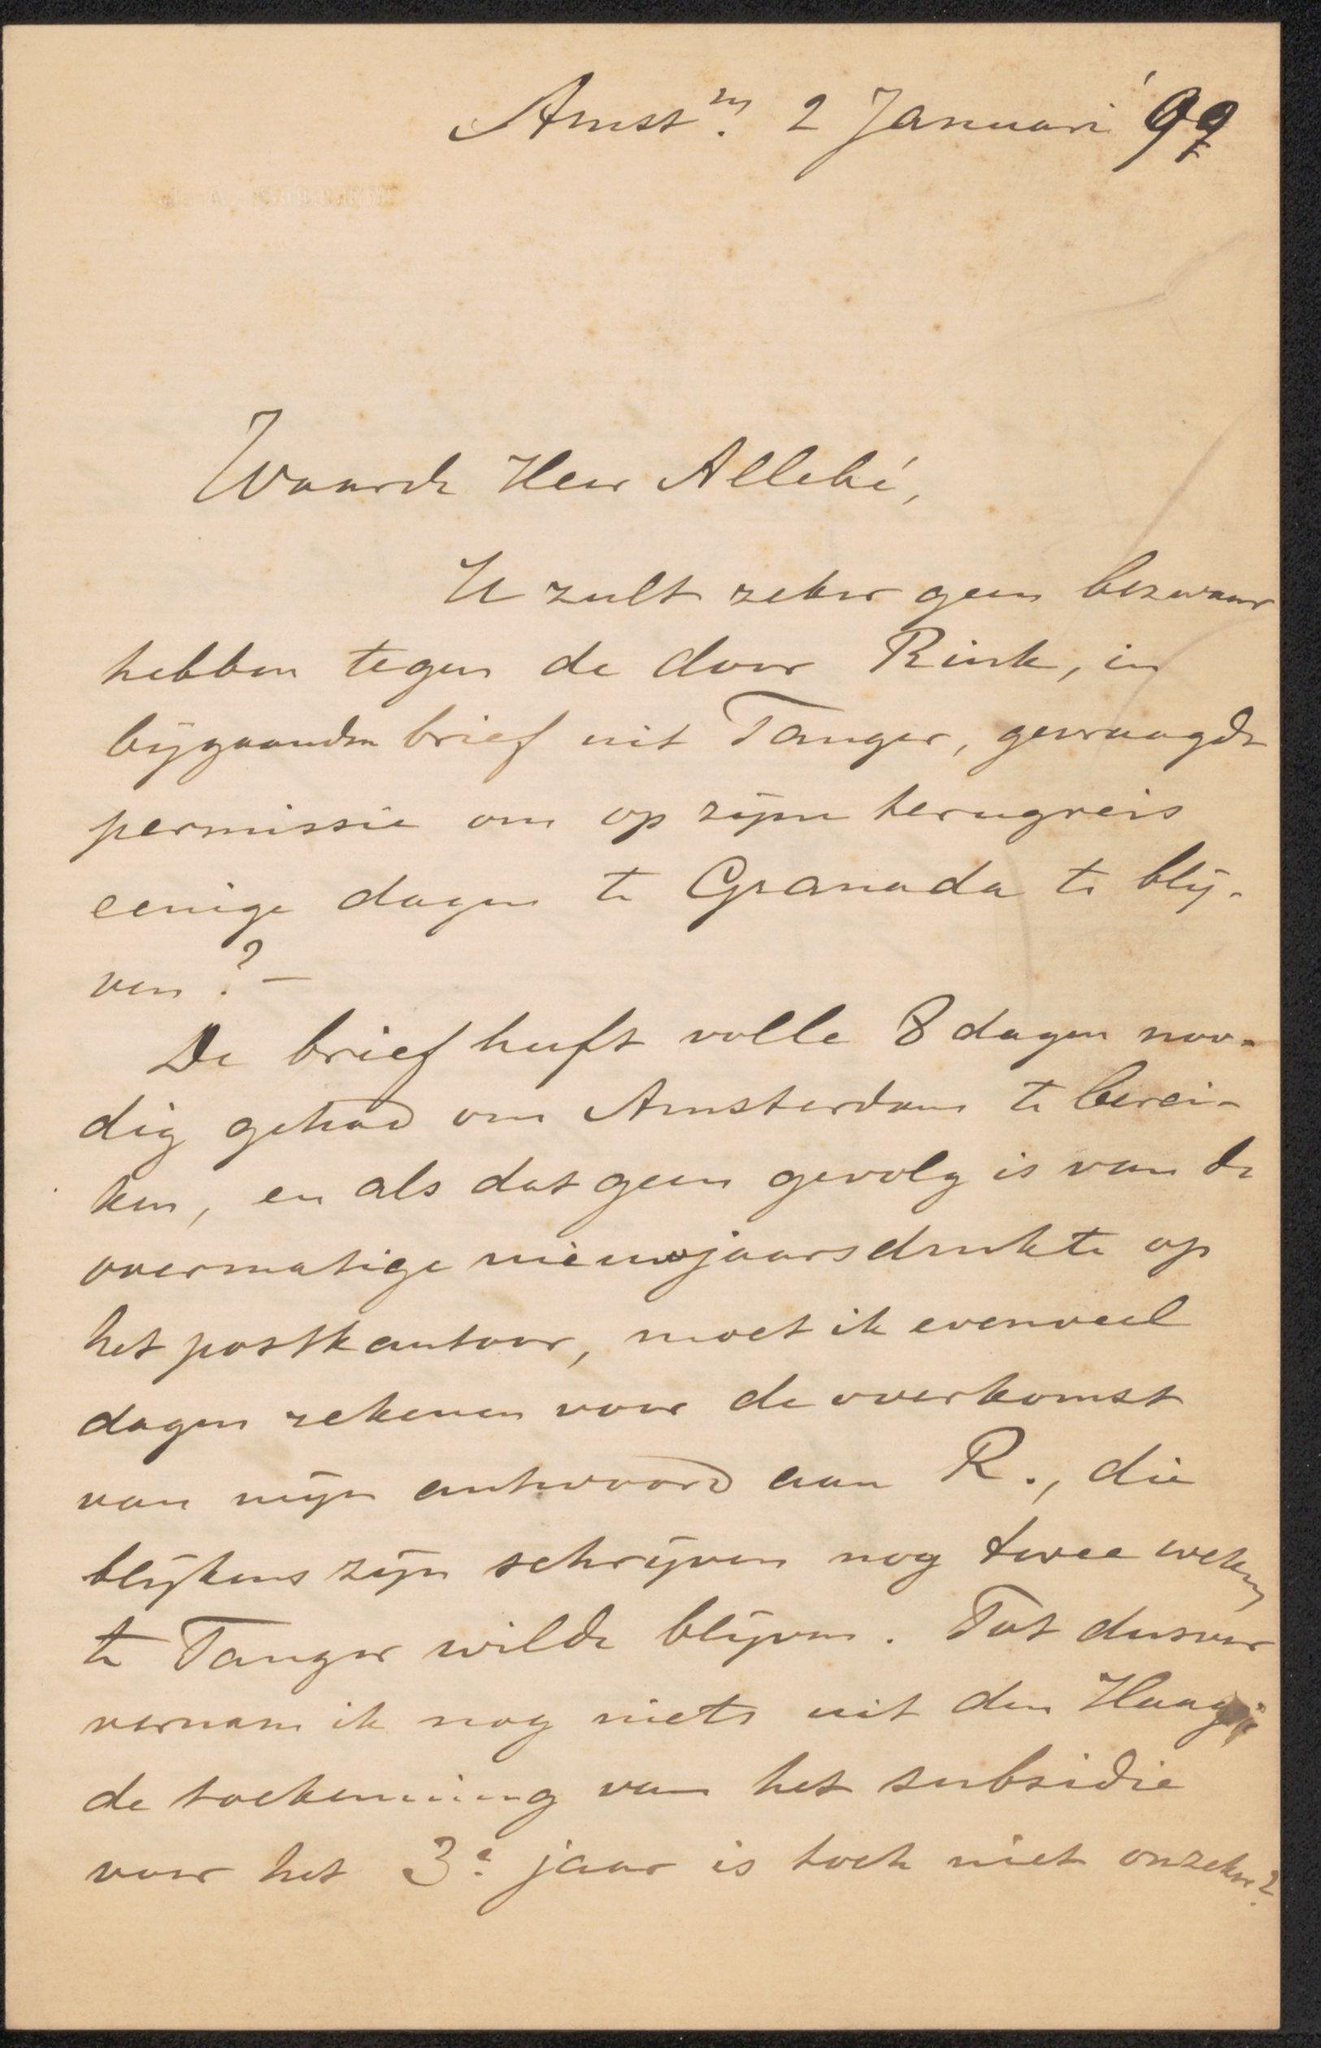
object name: letter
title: Brief aan August Allebé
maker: jérôme alexander sillem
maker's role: politician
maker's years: 1840-1912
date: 1890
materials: ink, paper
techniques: pen, printing, writing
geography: amsterdam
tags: august allebé, haarlem, painter, print maker, draughtsman, jac van looij, veghel, paul rink, amsterdam, jonkheer jan six, family life, travelling; tourism, education, tuition of the artist (in general), painting (including book-illumination, miniature-painting), money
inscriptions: name: ‘J.A. SILLEM’